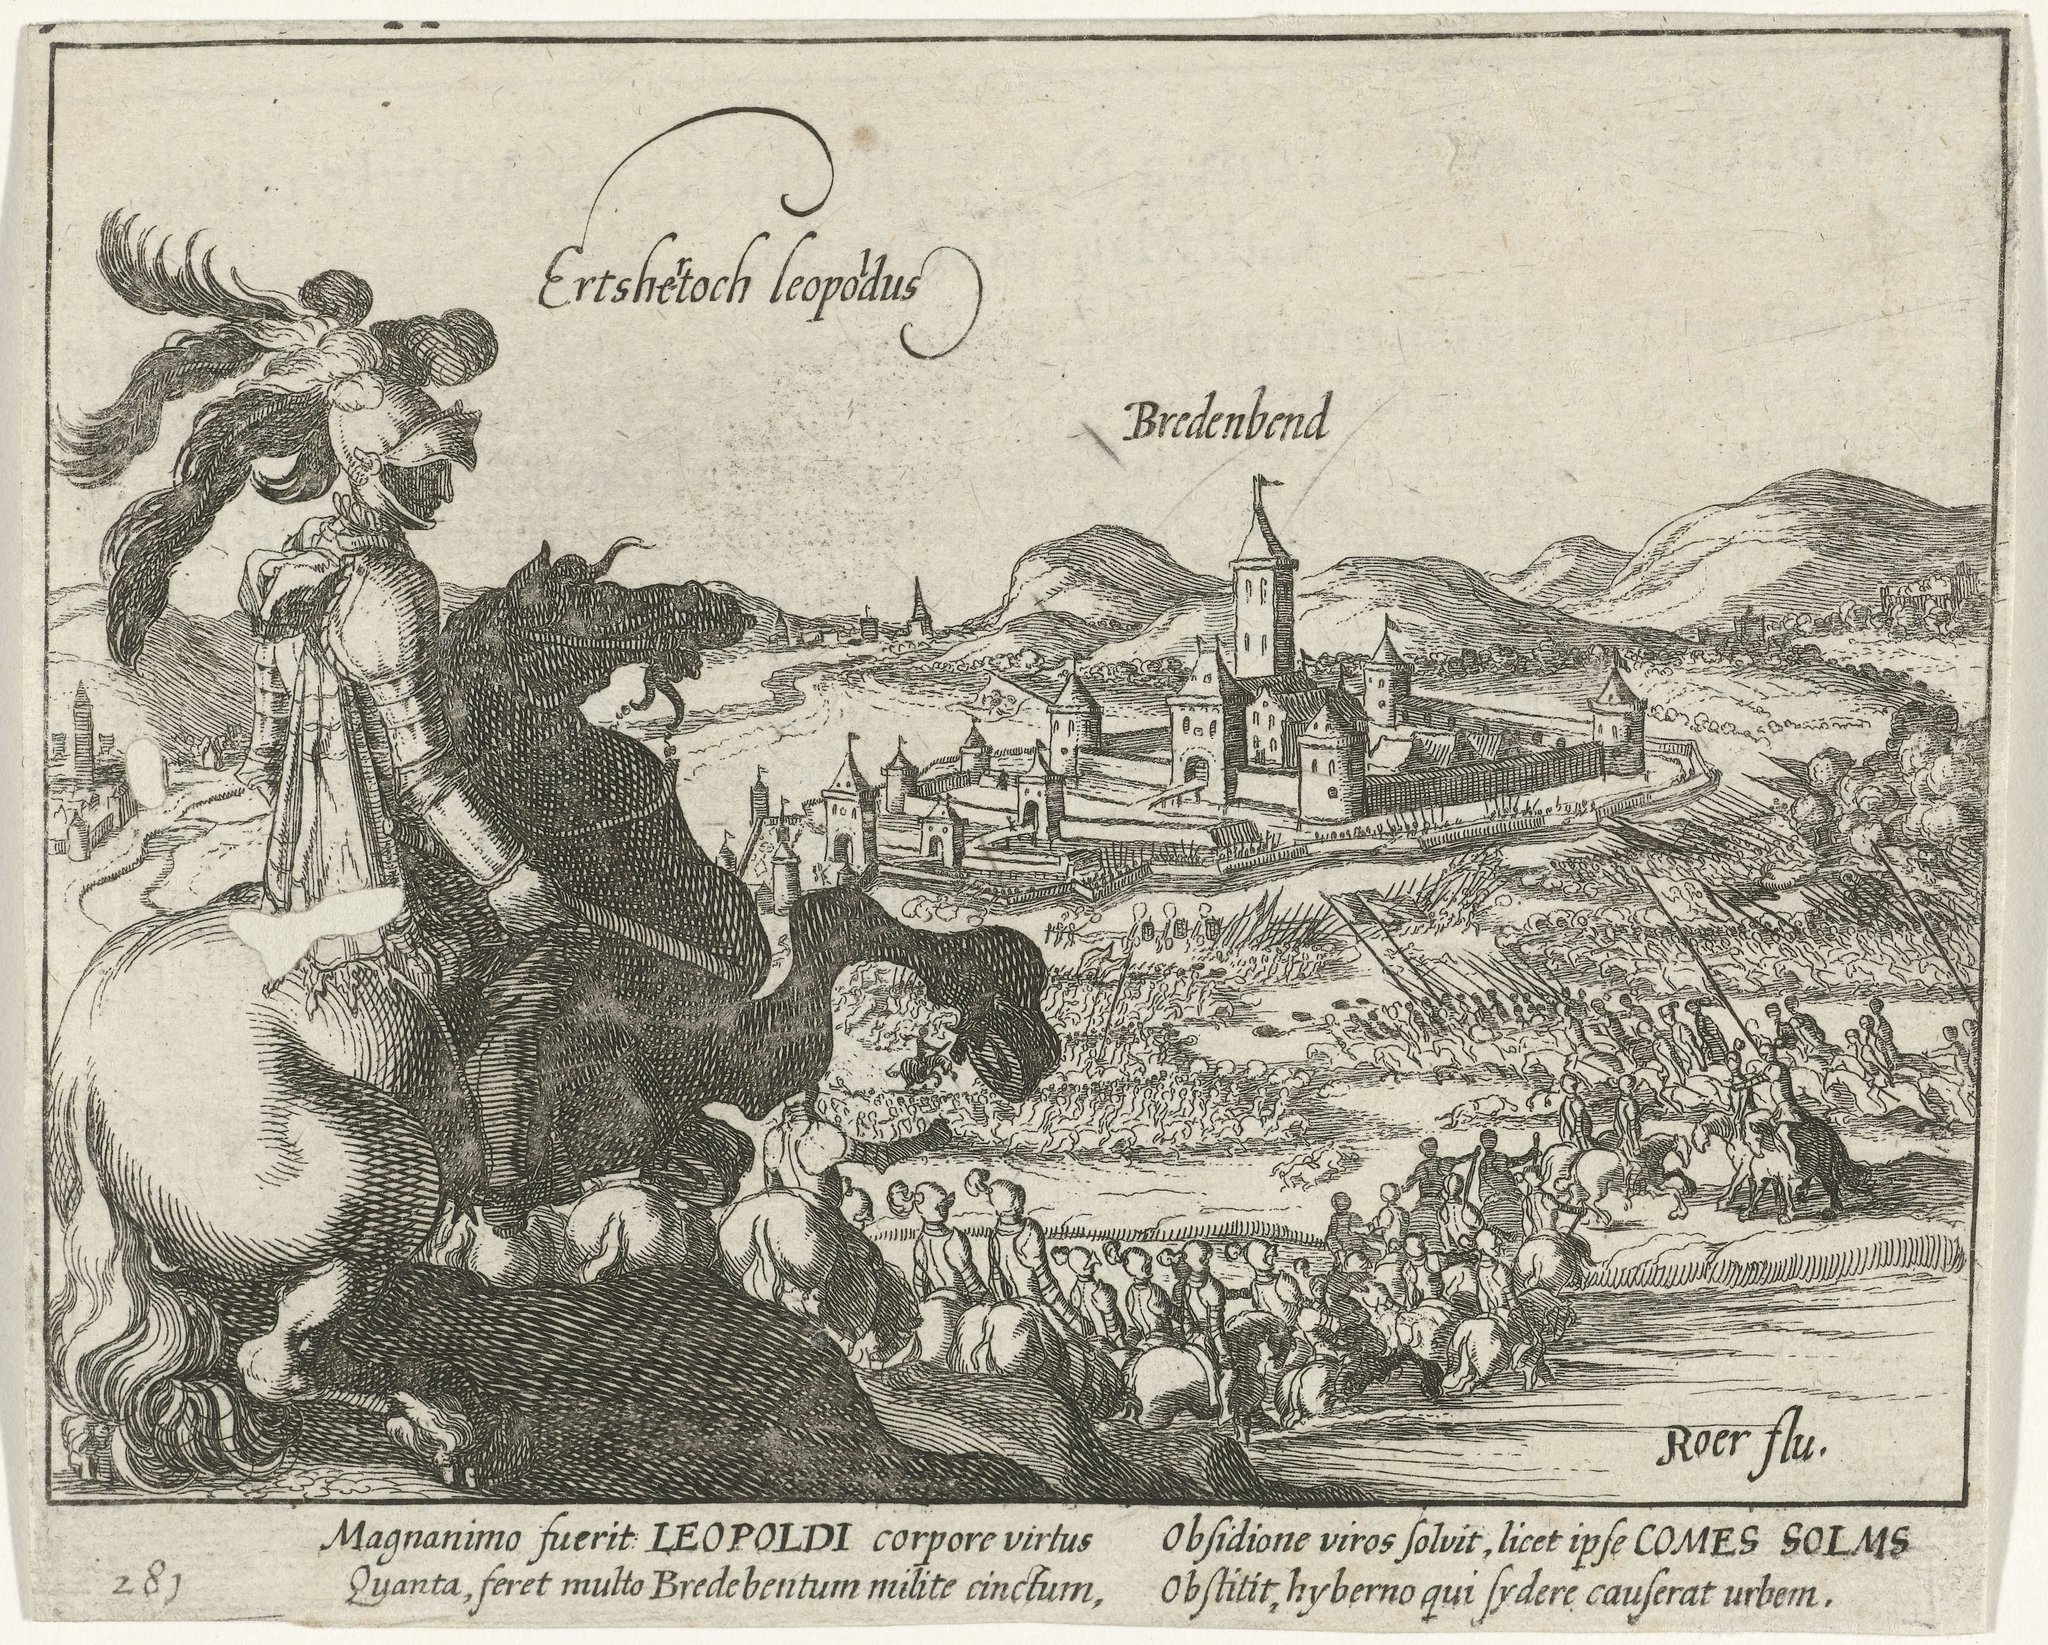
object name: history print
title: Aartshertog Leopold ontzet Breitenbend, 1610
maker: simon frisius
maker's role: print maker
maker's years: 1570-1628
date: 1613-1615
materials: paper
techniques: etching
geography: northern netherlands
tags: leopold v (aartshertog van oostenrijk), raising the siege with outside assistance, relief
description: Aartshertog Leopold ontzet Breitenbend, 12 maart 1610. Op de voorgrond ziet de aartshertog te paard hoe zijn leger de rivier de Ruhr doorsteekt op weg naar de stad Breitenbend, dat door het Staatse leger belegerd wordt. Met onderschrift van 4 regels in het Latijn. Genummerd: 281. Bedrukt op achterzijde met tekst in het Latijn.